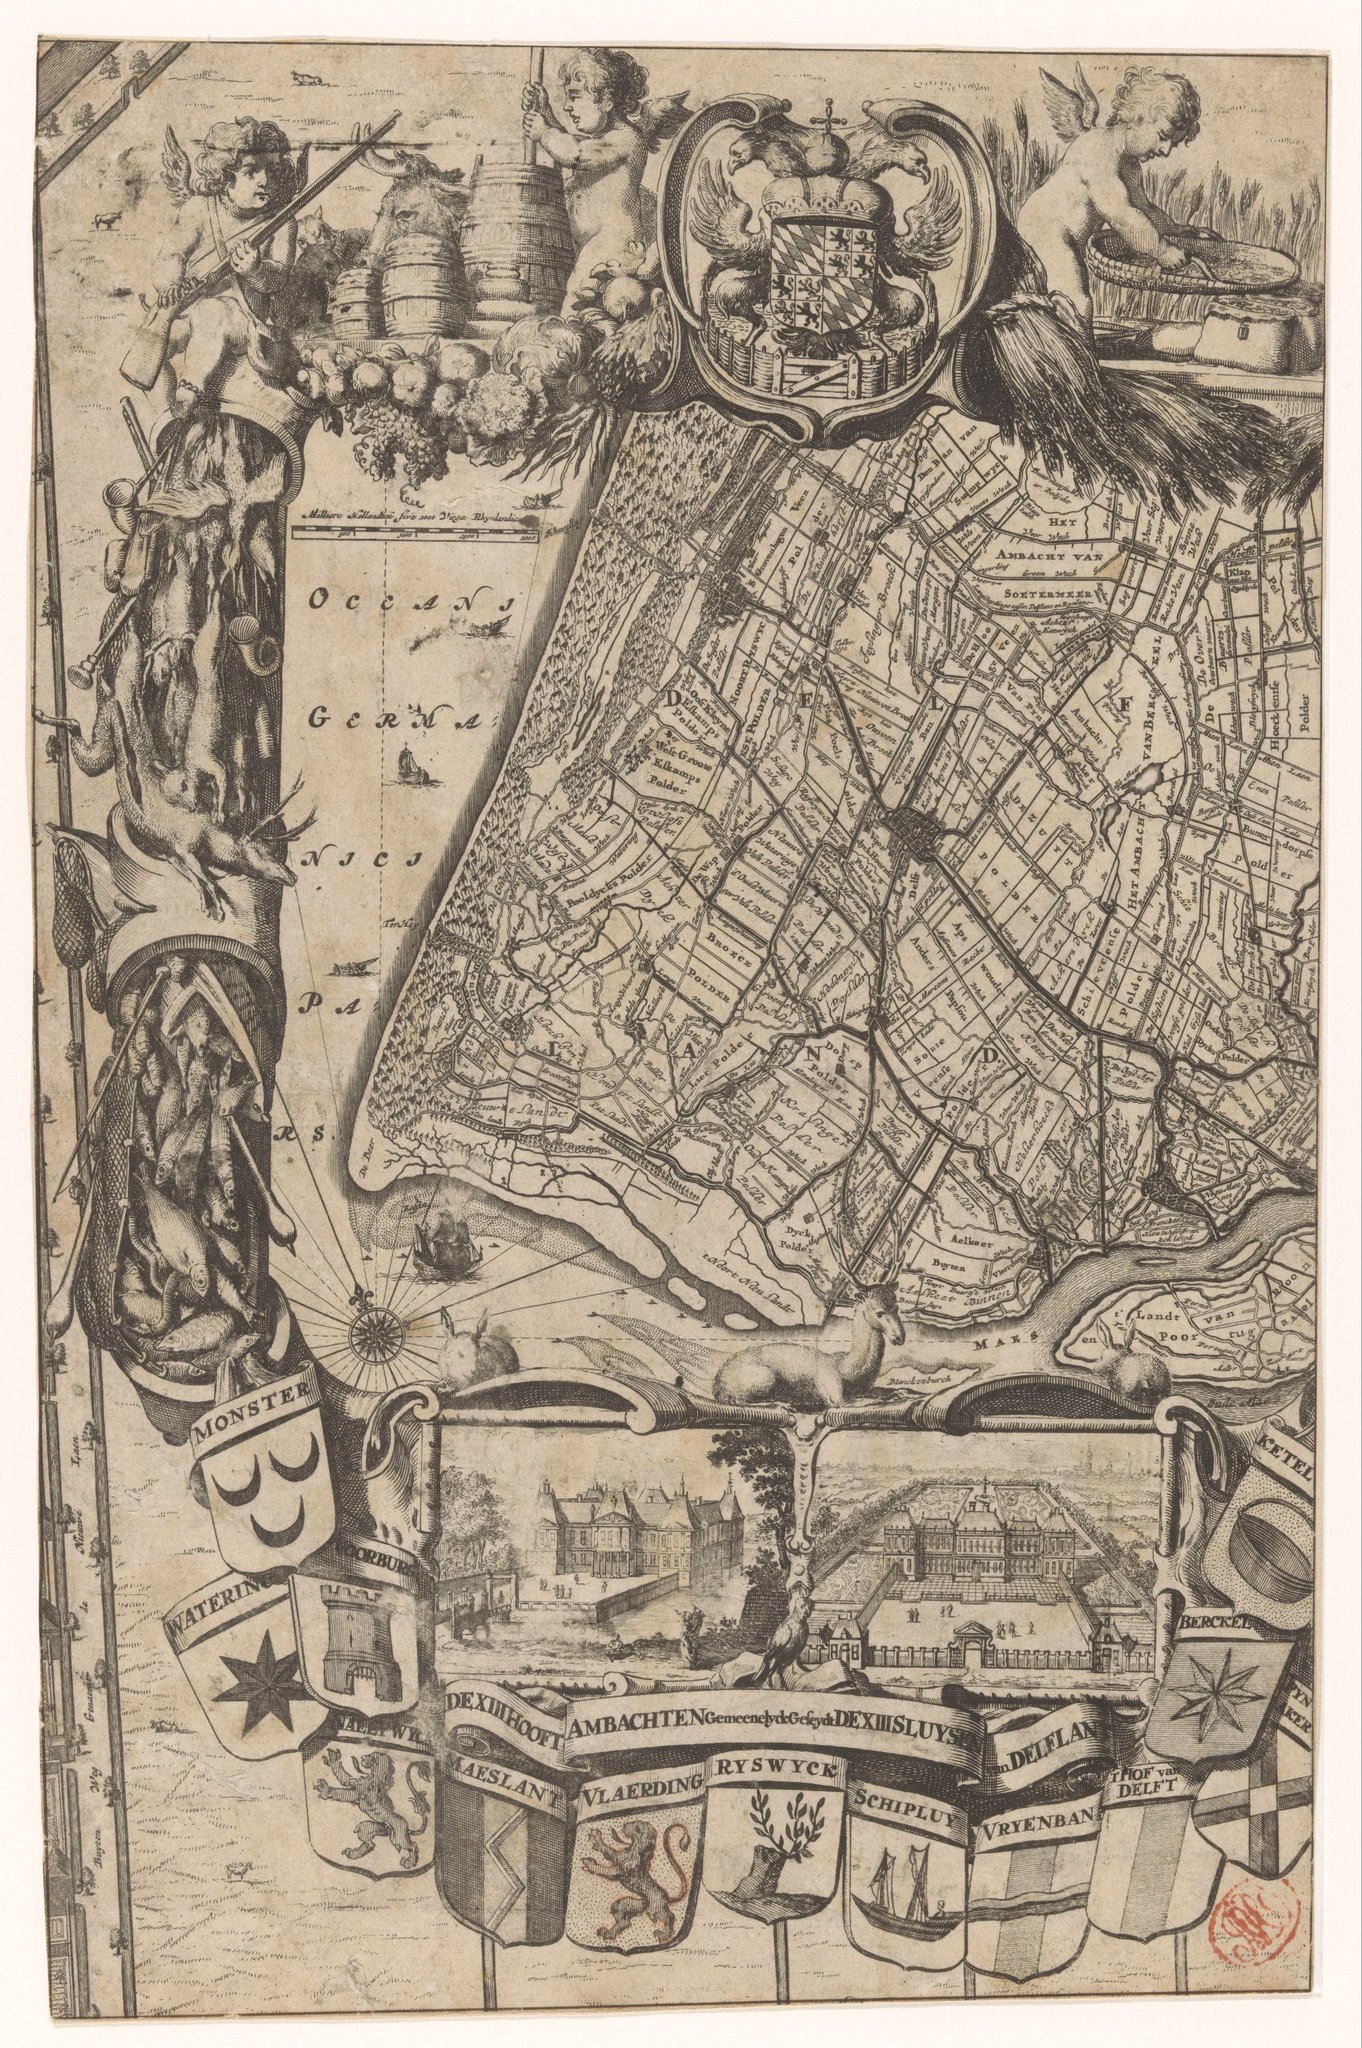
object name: map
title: Inzetkaart van het Hoogheemraadschap van Delfland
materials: ink, paper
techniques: engraving, etching, pen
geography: amsterdam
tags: commercial fishery, coat of arms (as symbol of the state, etc.) (+ city; municipal), maps of separate countries or regions, hunting, chase, agriculture, maps of cities, delft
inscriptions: inscription, collector's mark: Lugt 195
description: Afgesneden van een proefdruk van een van de bladen (voor latere staat zie RP-P-AO-11-8A-2) van de plattegrond van de zogenaamde Kaart Figuratief (Caerte figuratyff / Kaerte figuratyf) van Delft, een wandkaart van Delft die voor het eerst werd uitgegeven in 1678. Zie RP-P-AO-11-8A voor meer informatie.